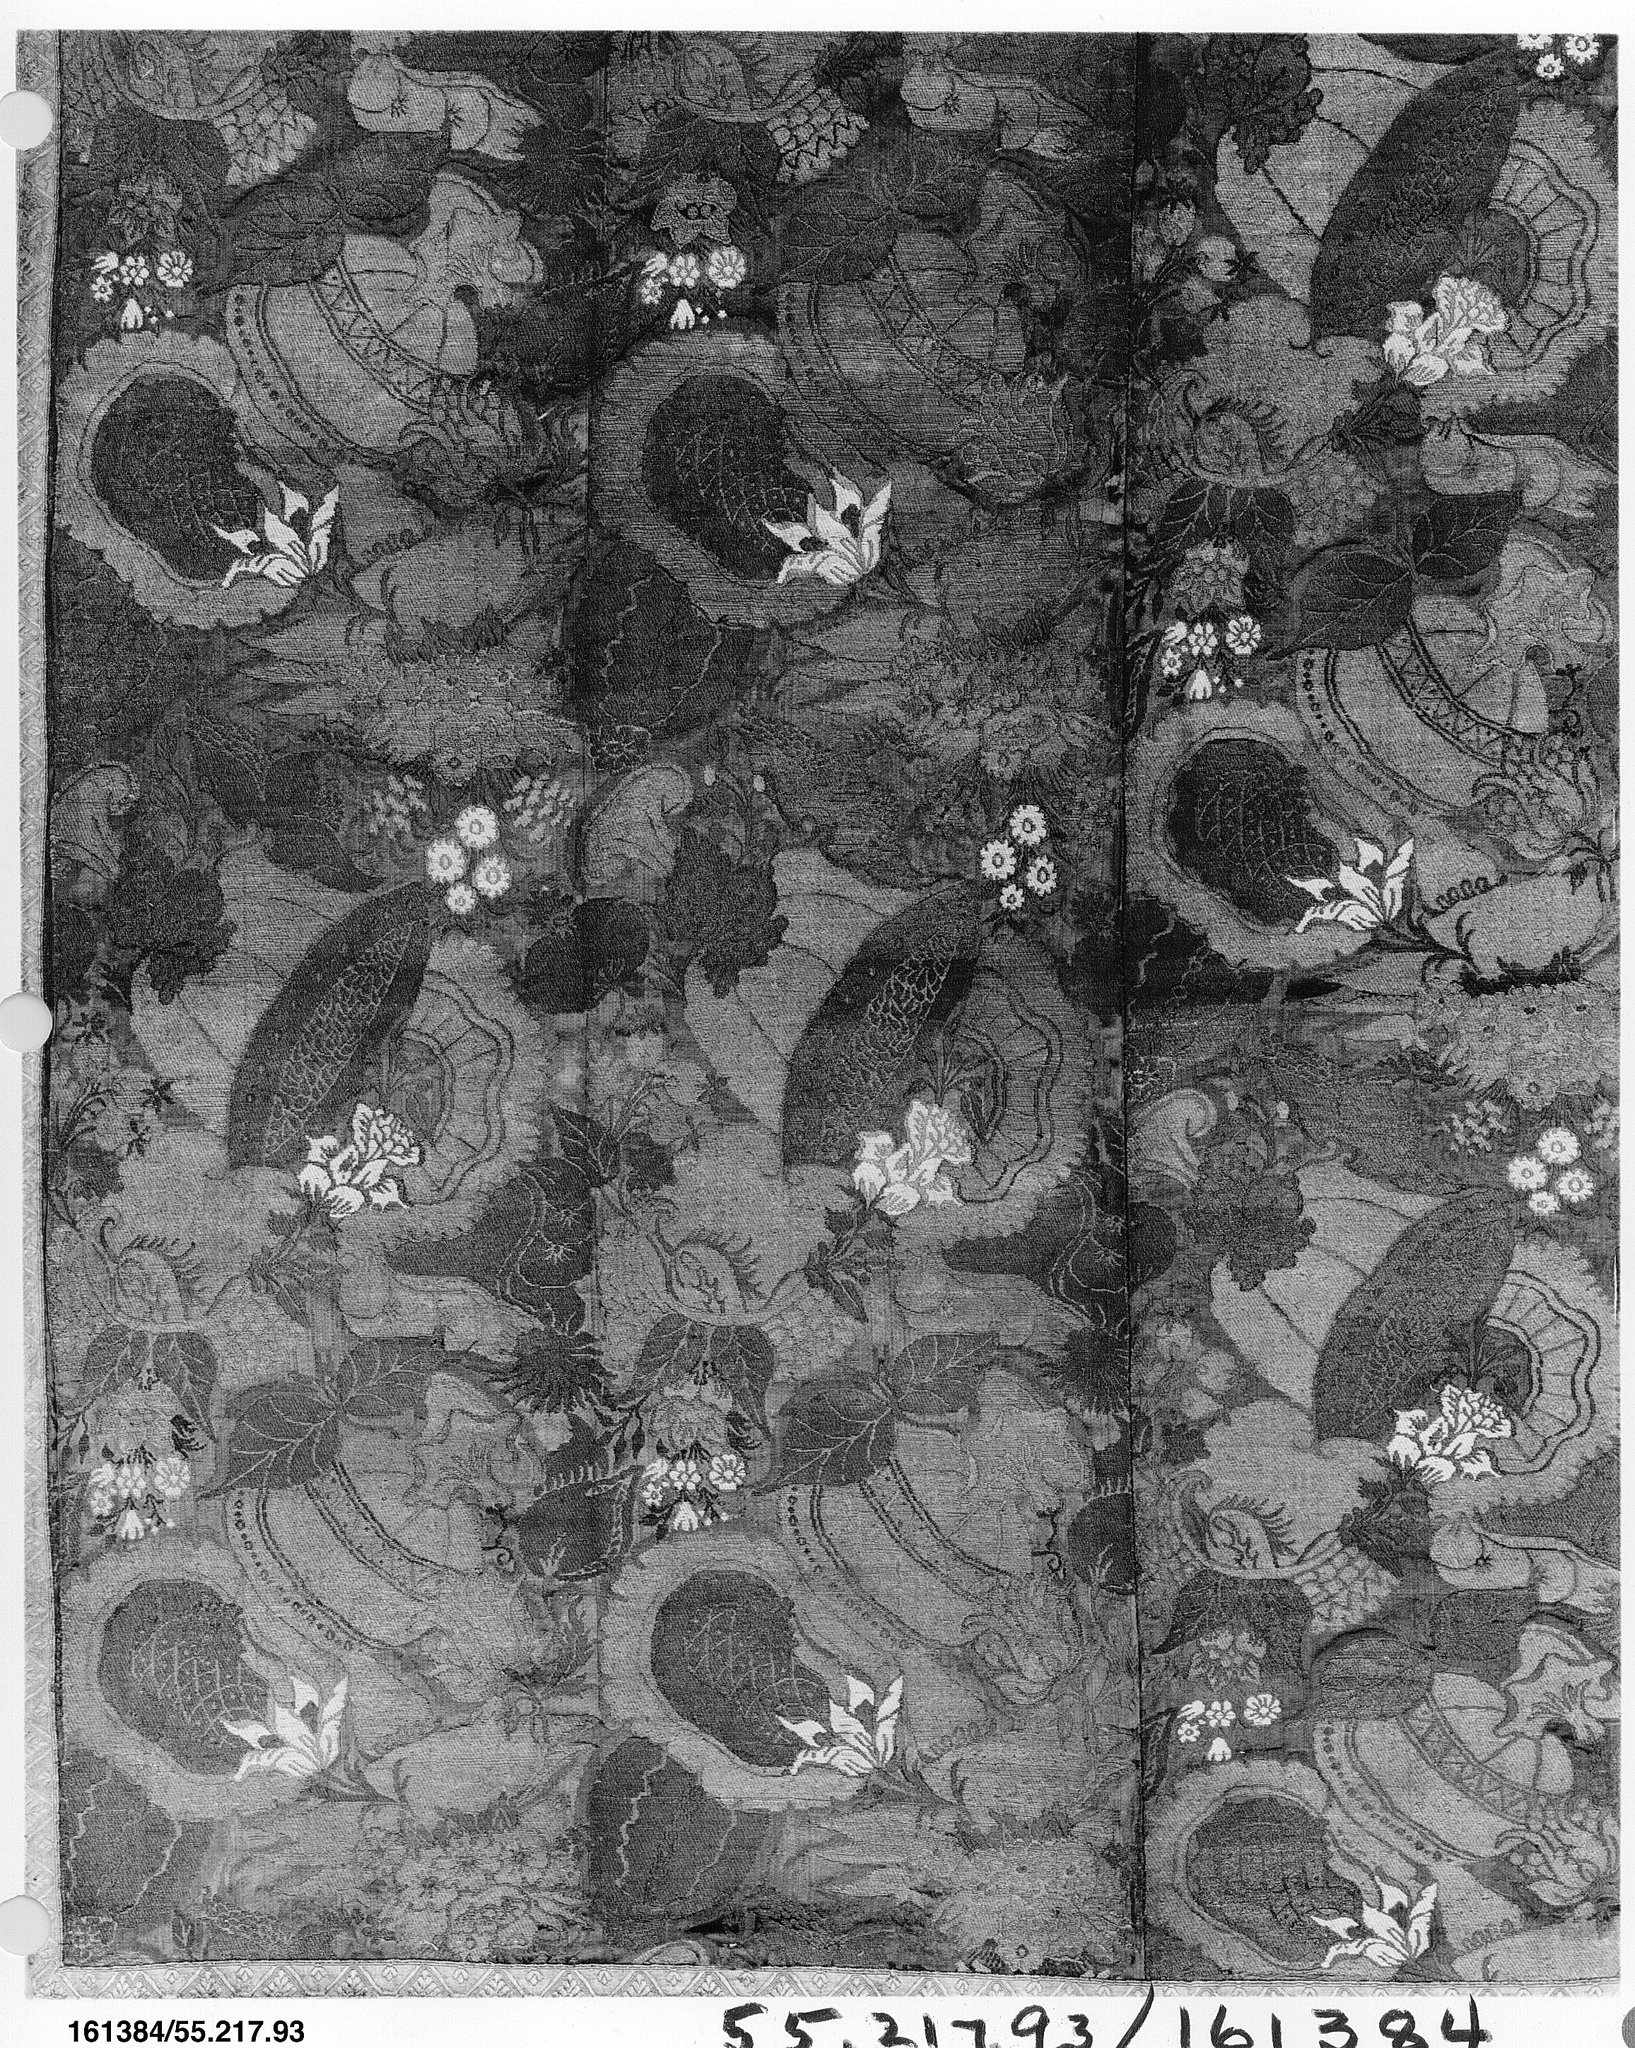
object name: piece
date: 1720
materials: metal thread, silk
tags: flowers,leaves